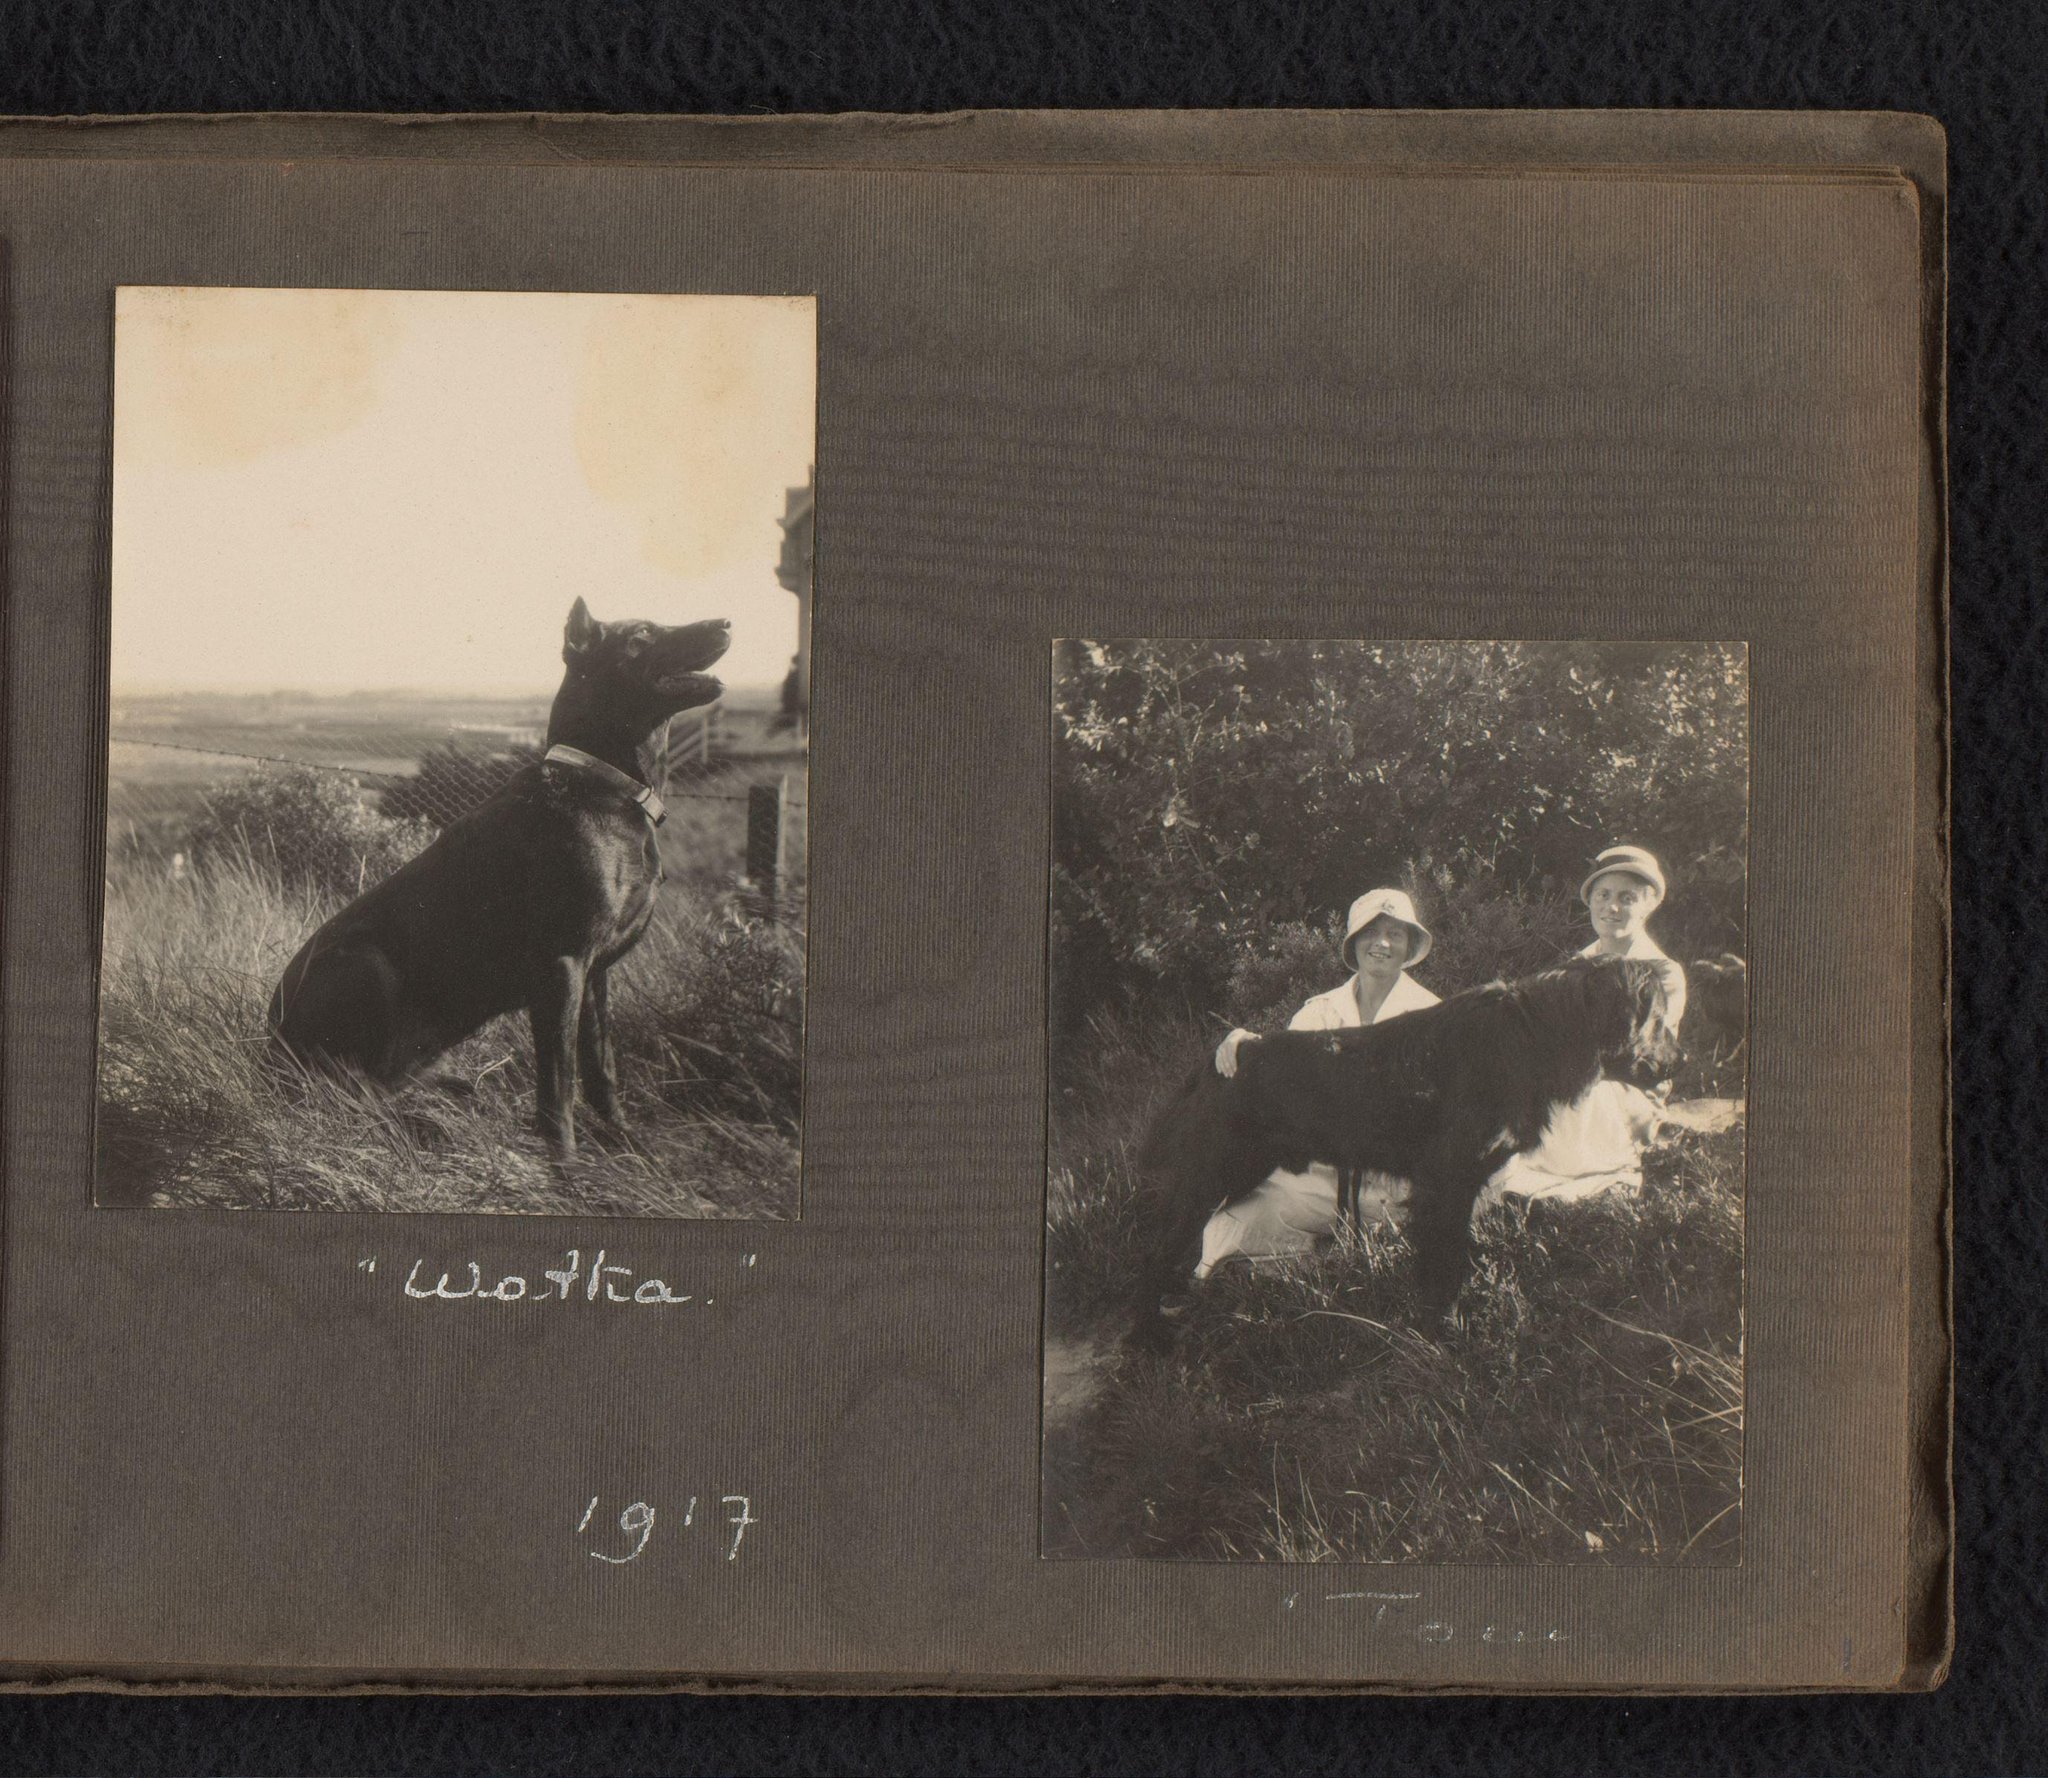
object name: album leaf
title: Twee foto's van hond Wotka met twee leden van familie Onnen-Van den Berg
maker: Anonymous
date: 1917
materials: paper, cardboard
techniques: gelatin silver print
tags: historical persons - bb - woman, dog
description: Deze foto's maken deel uit van een album.